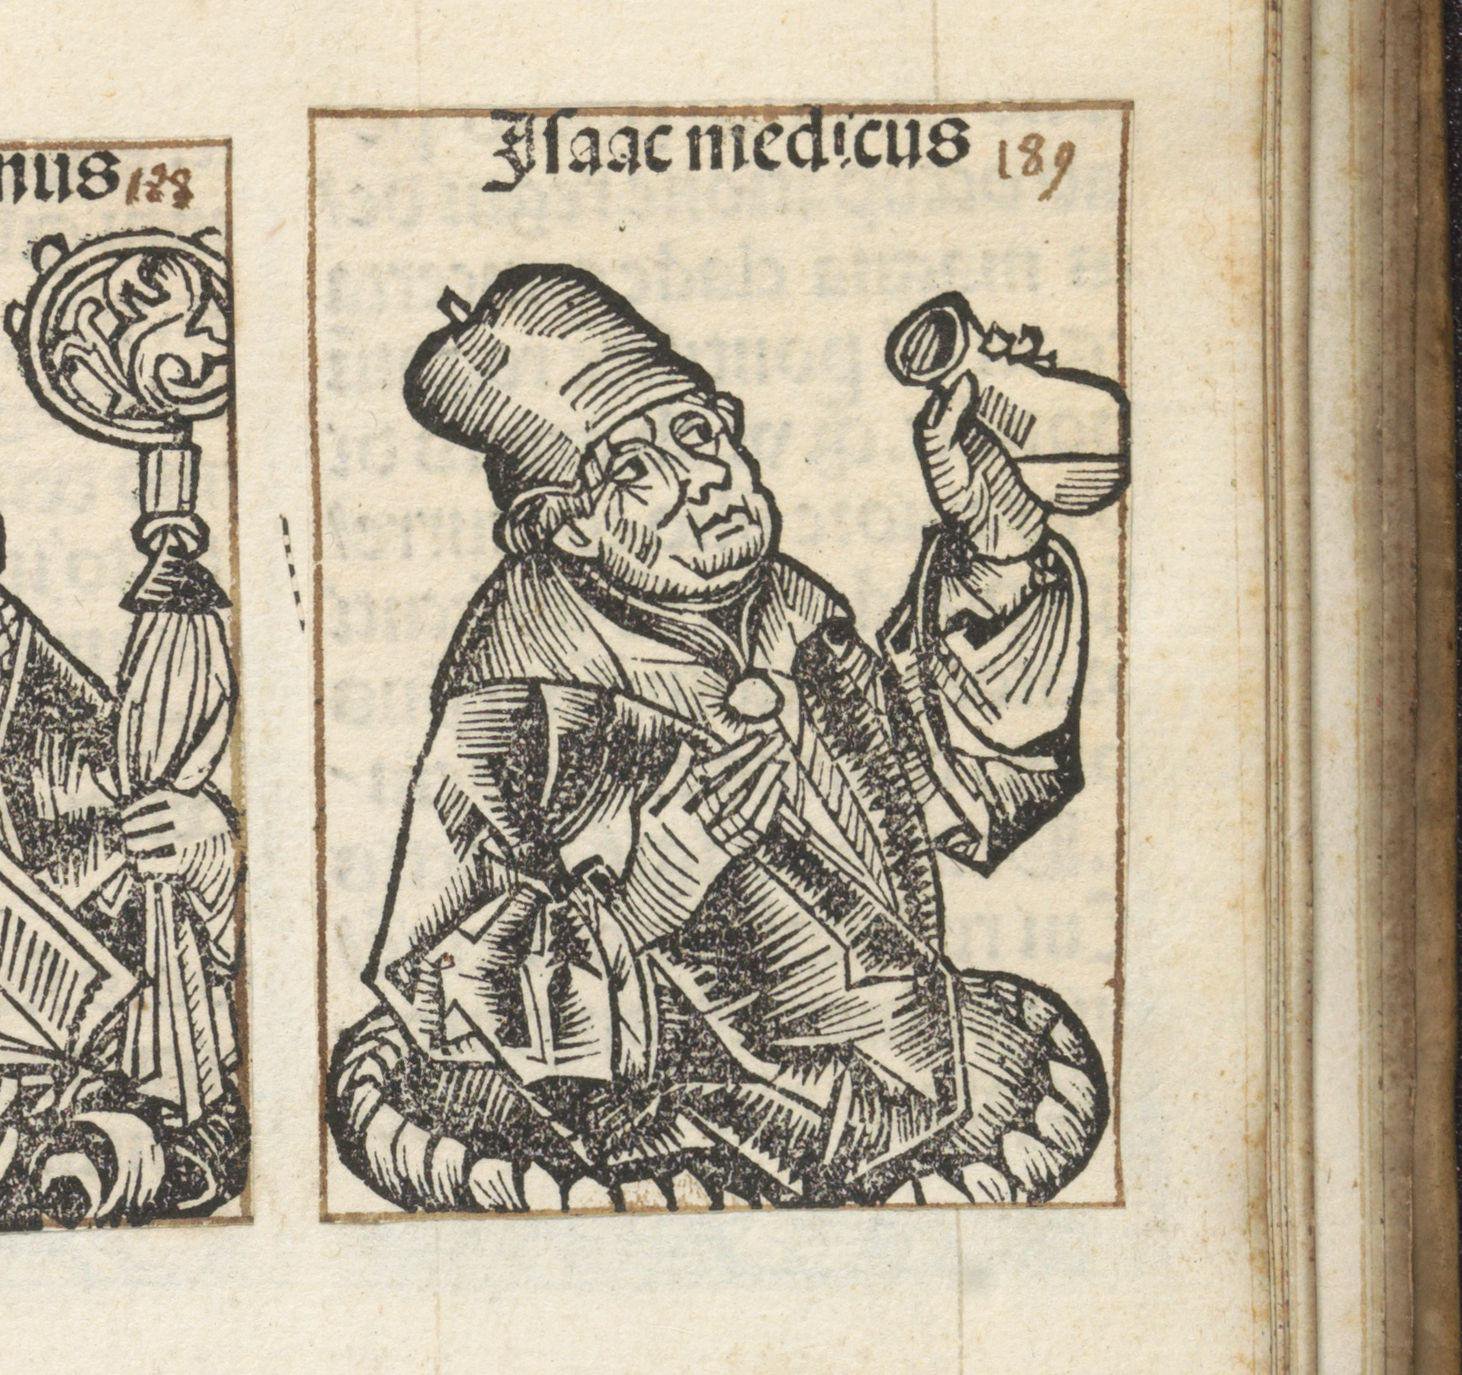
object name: album leaf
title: Liber Chronicarum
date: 1493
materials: paper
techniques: letterpress printing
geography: nuremberg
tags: examination of urine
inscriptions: inscription: ‘189’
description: De houtsnede wordt herhaaldelijk gebruikt als boekillustratie in de Liber Chronicarum (of Neurenbergkroniek) van Hartmann Schedel, verschenen in het Latijn en Duits in 1493. Zie de Latijnse uitgave, folio 192v.